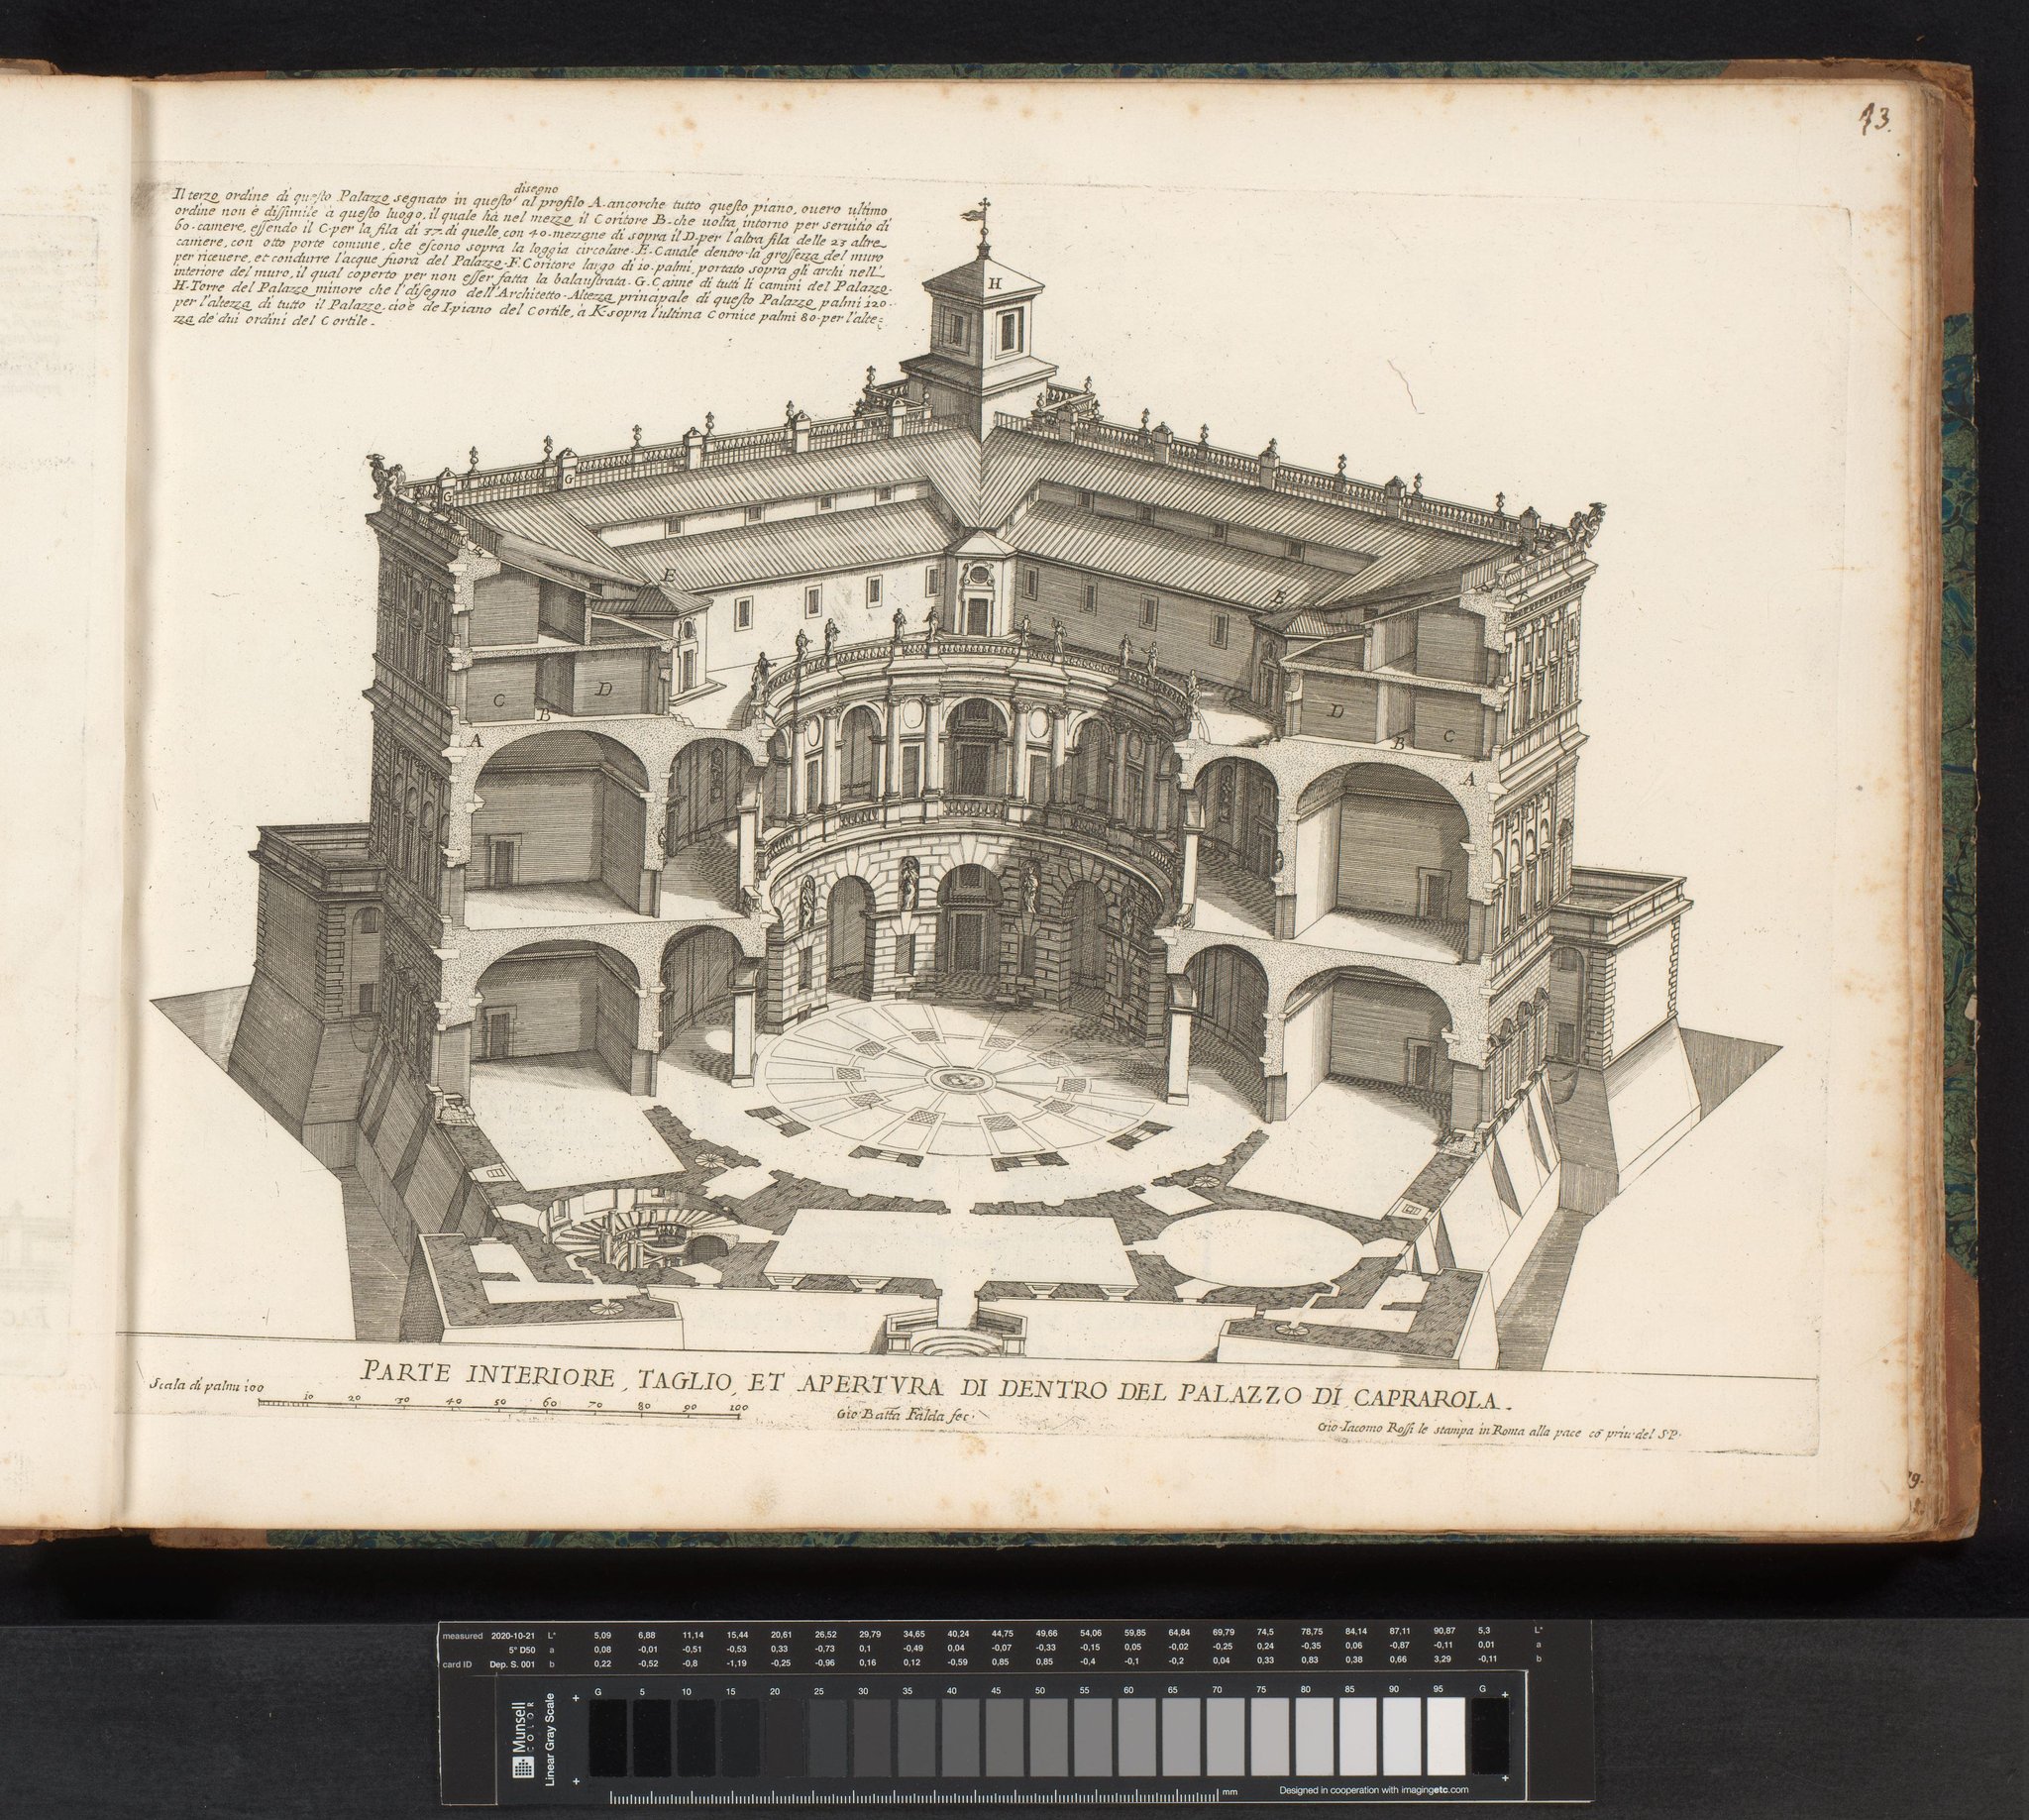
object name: album leaf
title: Romeinse paleizen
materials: paper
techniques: etching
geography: rome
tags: palace, façade (of house or building), inner court of palace or 'hôtel'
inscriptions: number: ‘43’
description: Deze prent maakt deel uit van de reeks getiteld: Palazzi di Roma. Deze reeks bestaat uit twee boeken. Boek één getiteld: Palazzi di Roma dei più celebri architetti..., bestaat uit 44 prenten die worden toegeschreven aan Giovanni Battista Falda (naam staat enkel op prent 27) en uitgegeven door Giovanni Giacomo de'Rossi. Deze 44 prenten zijn bekend in twee staten (met en zonder nummer). Boek twee getiteld: Nuovi disegni dell'architetture... libro secondo, bevat 66 prenten door Giovanni Battista Falda en Simone Felice. Deze 66 prenten zijn bekend in twee staten (met en zonder nummer).